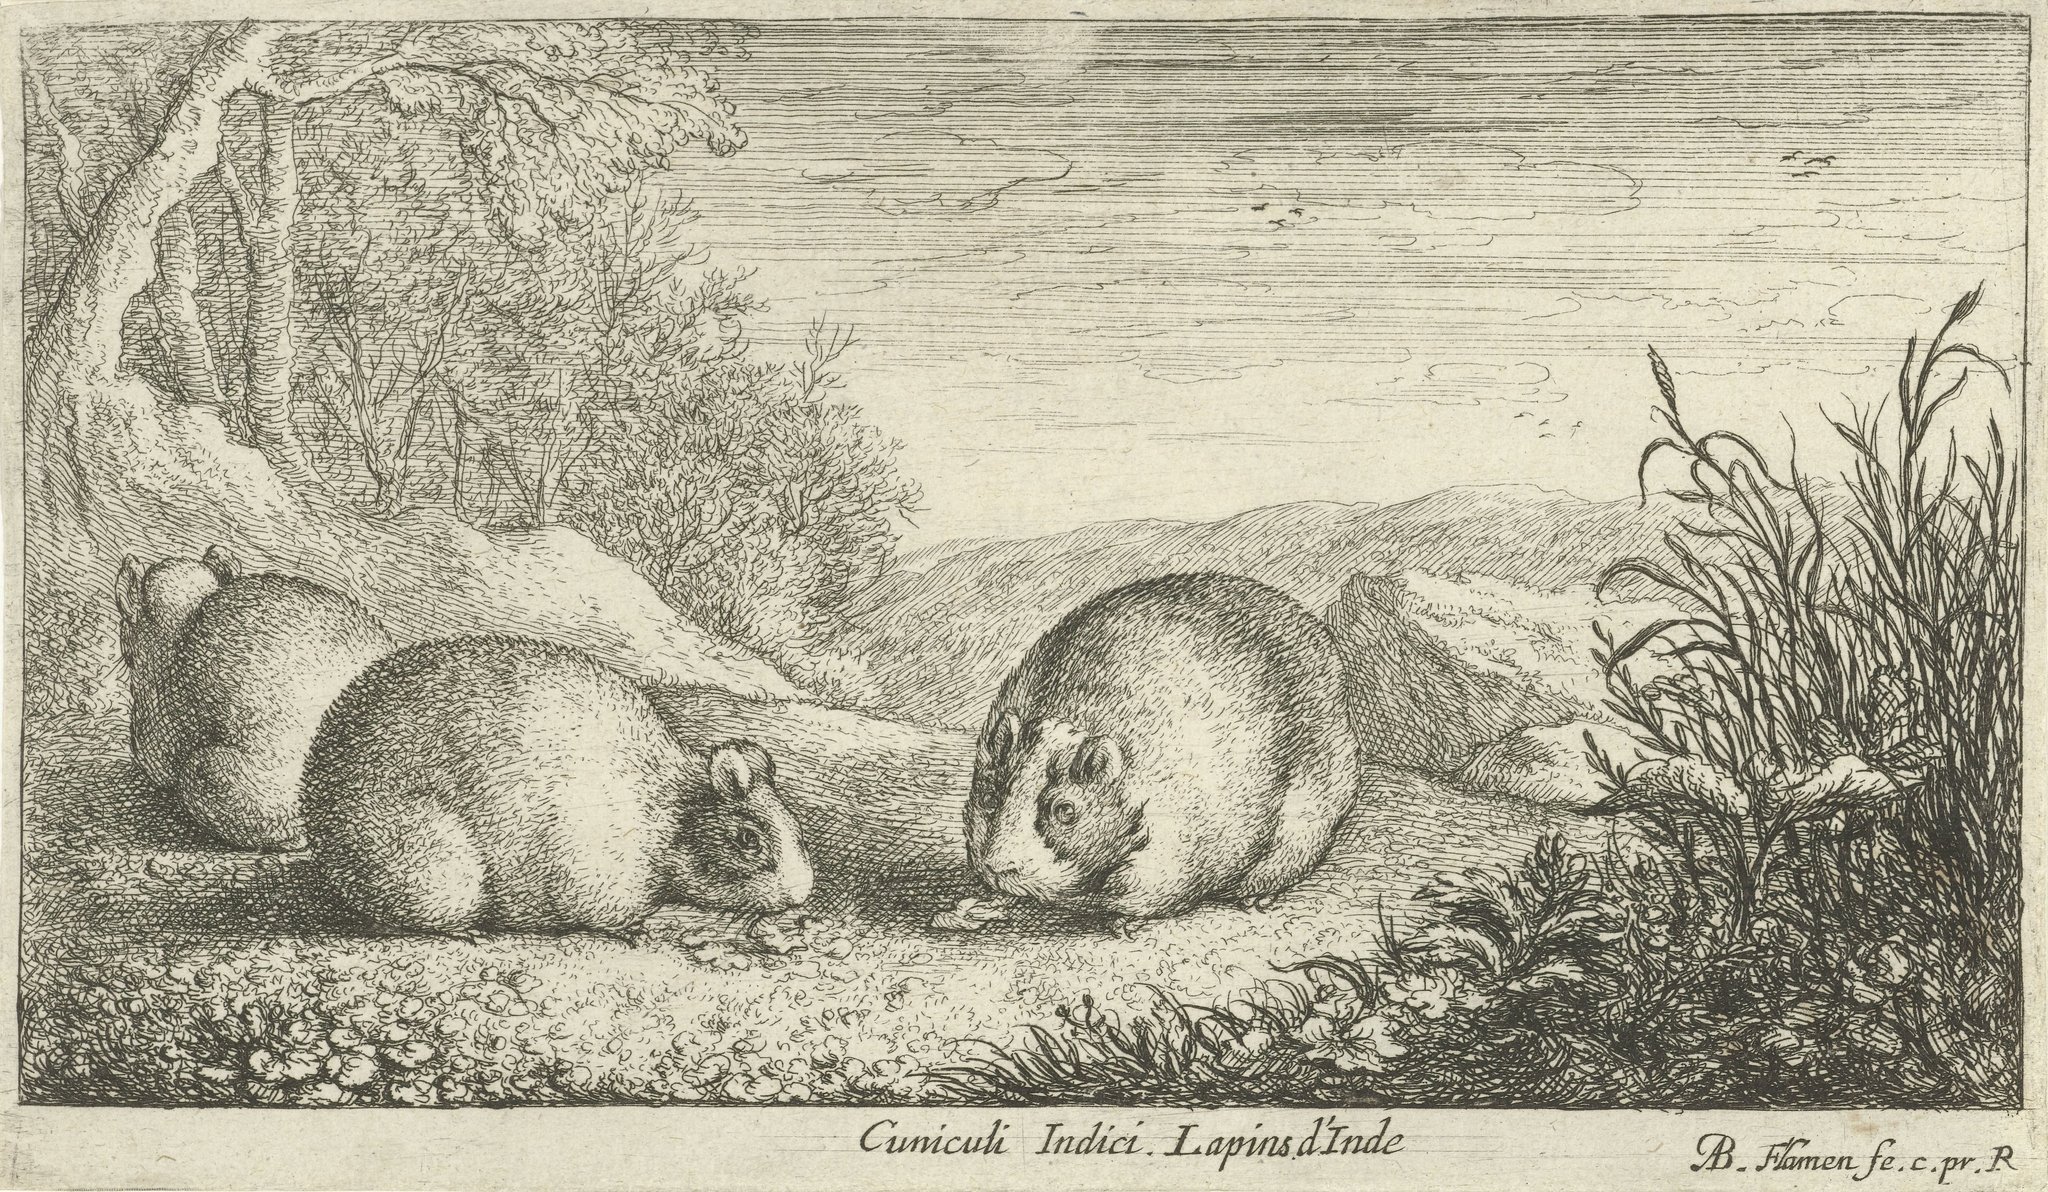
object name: print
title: Verschillende diersoorten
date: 1648-1691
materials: paper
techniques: etching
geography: france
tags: rodents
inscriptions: collector's mark: Lugt 240